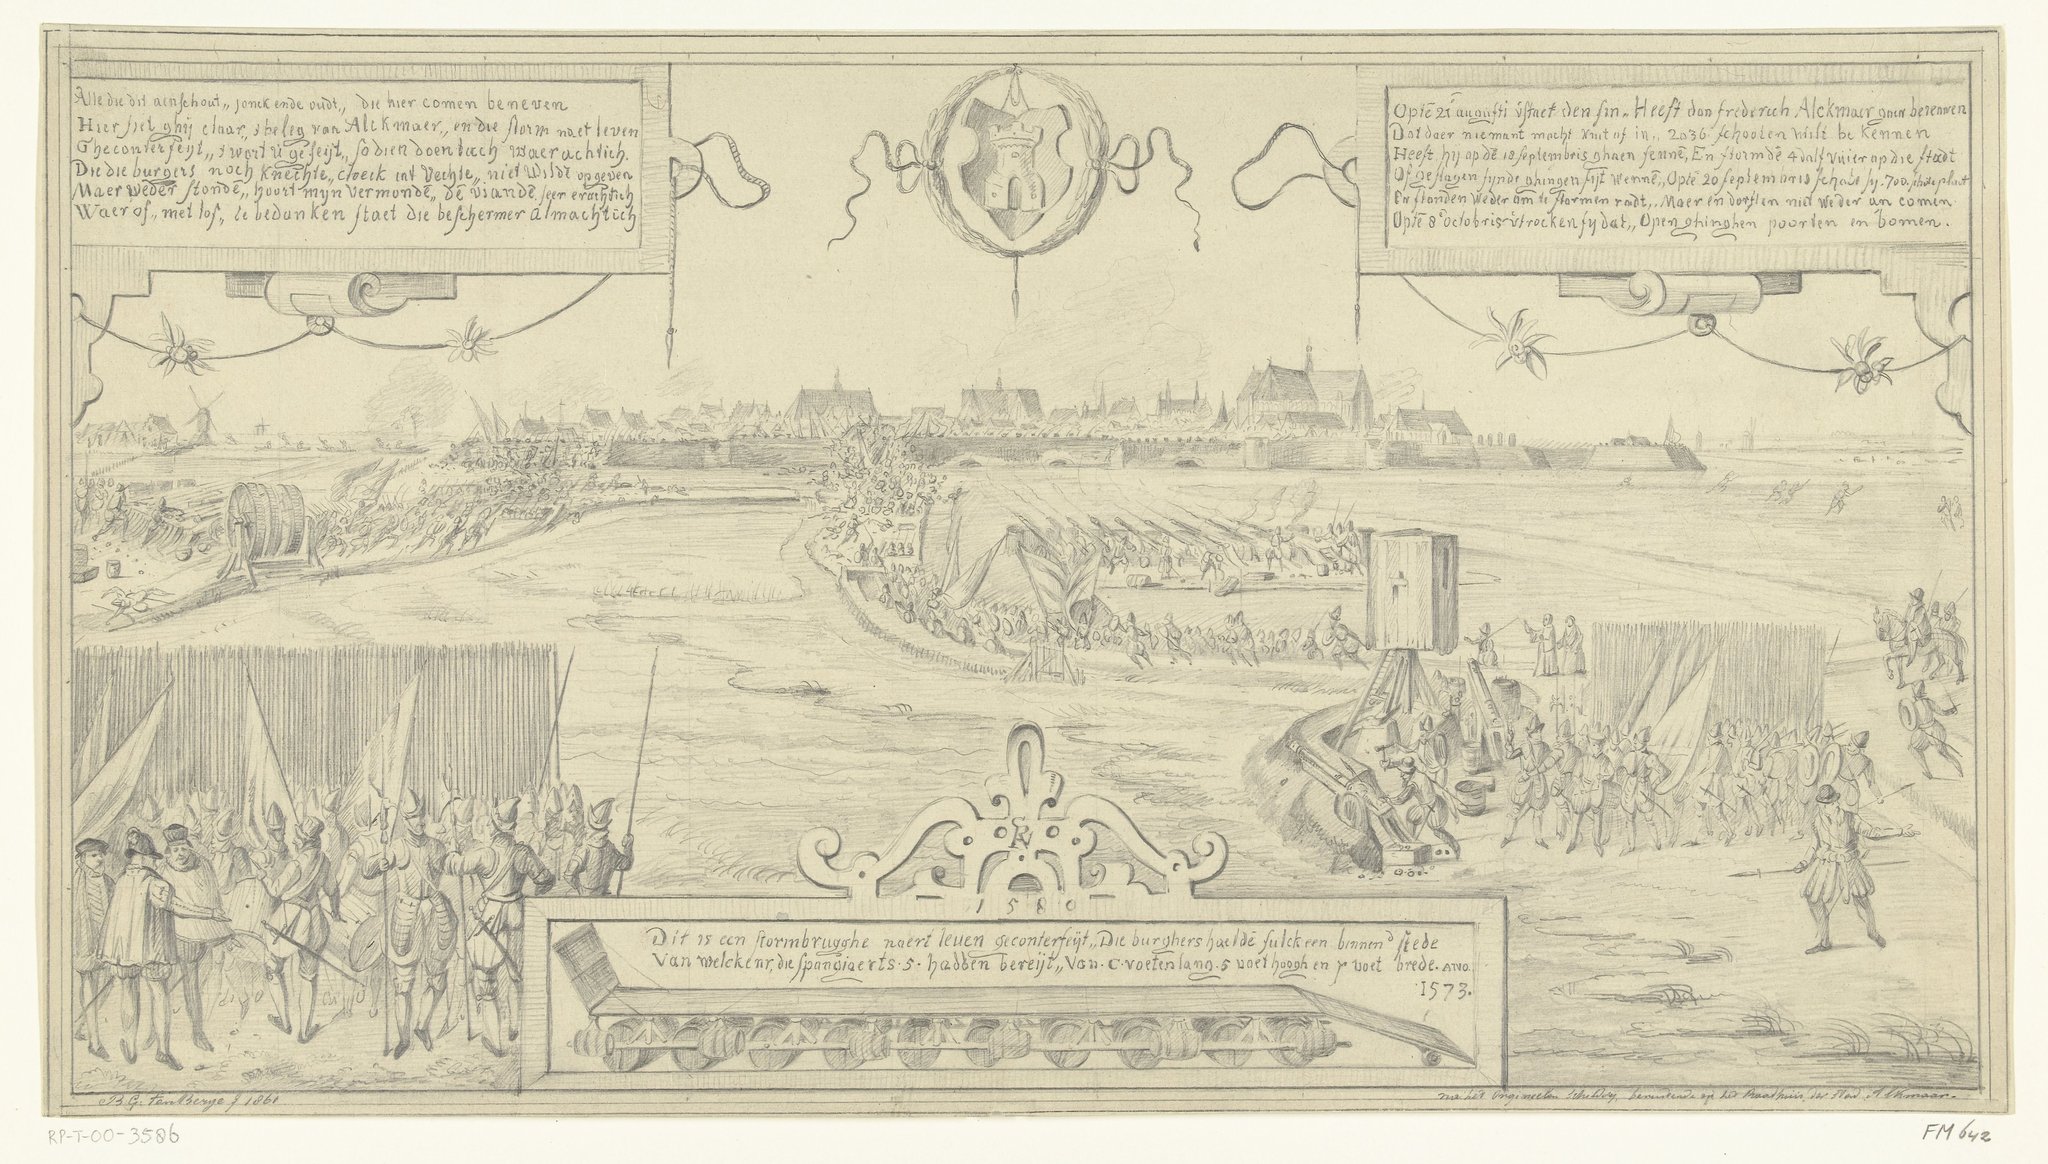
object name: drawing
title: Beleg van Alkmaar in 1573, gezien vanuit het noorden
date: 1861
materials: paper, pencil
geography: netherlands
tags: siege, position war, fortifications, military engineering, siege arms, e.g.: battering ram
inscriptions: date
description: Beleg van Alkmaar in 1573, gezien vanuit het noorden. Kopie naar het schilderij van Pieter Adriaensz Cluyt uit 1580. Van links en rechts bestormen soldaten de stad. Op de voorgrond cartouche met tekst bij een afbeelding van een stormbrug zoals gebruikt door de Spanjaarden. Links- en rechtsboven cartouches met teksten in het Nederlands, in het midden het stadswapen.